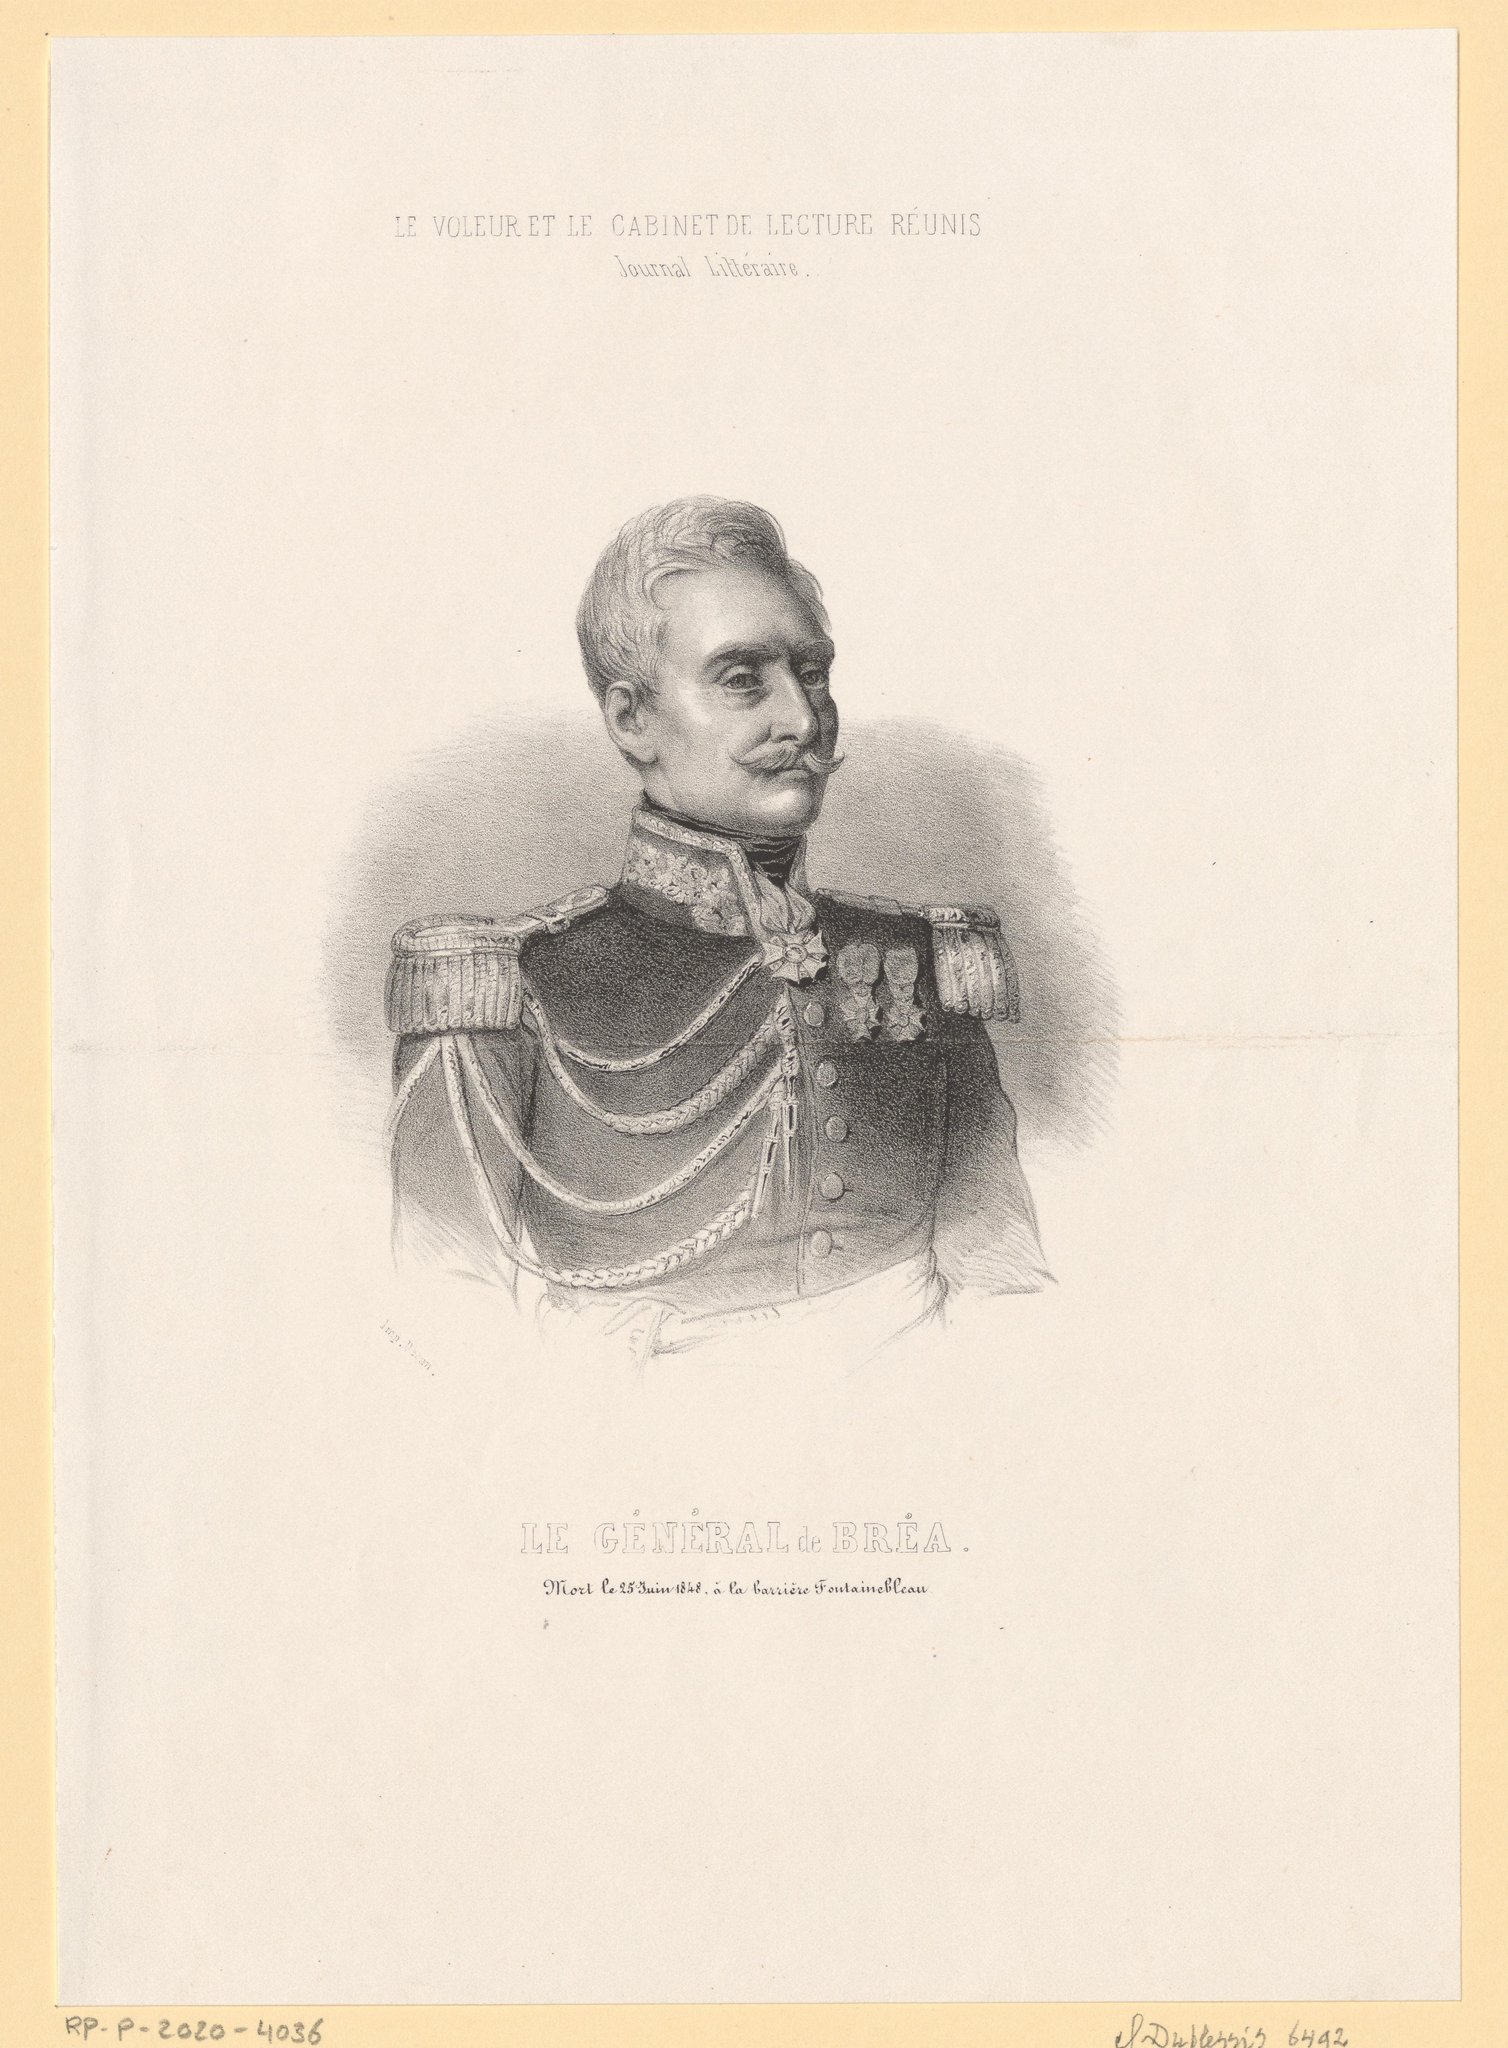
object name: print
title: Portret van Jean Baptiste Fidèle Bréa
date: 1848-1853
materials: paper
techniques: lithograph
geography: paris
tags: commander-in-chief, general, marshal, historical persons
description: Prent uit: Le voleur et le cabinet de lecture réunis, 1842-1856.